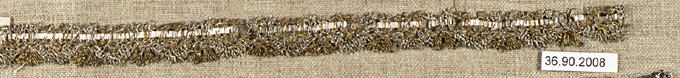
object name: piece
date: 1701-1800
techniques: lace